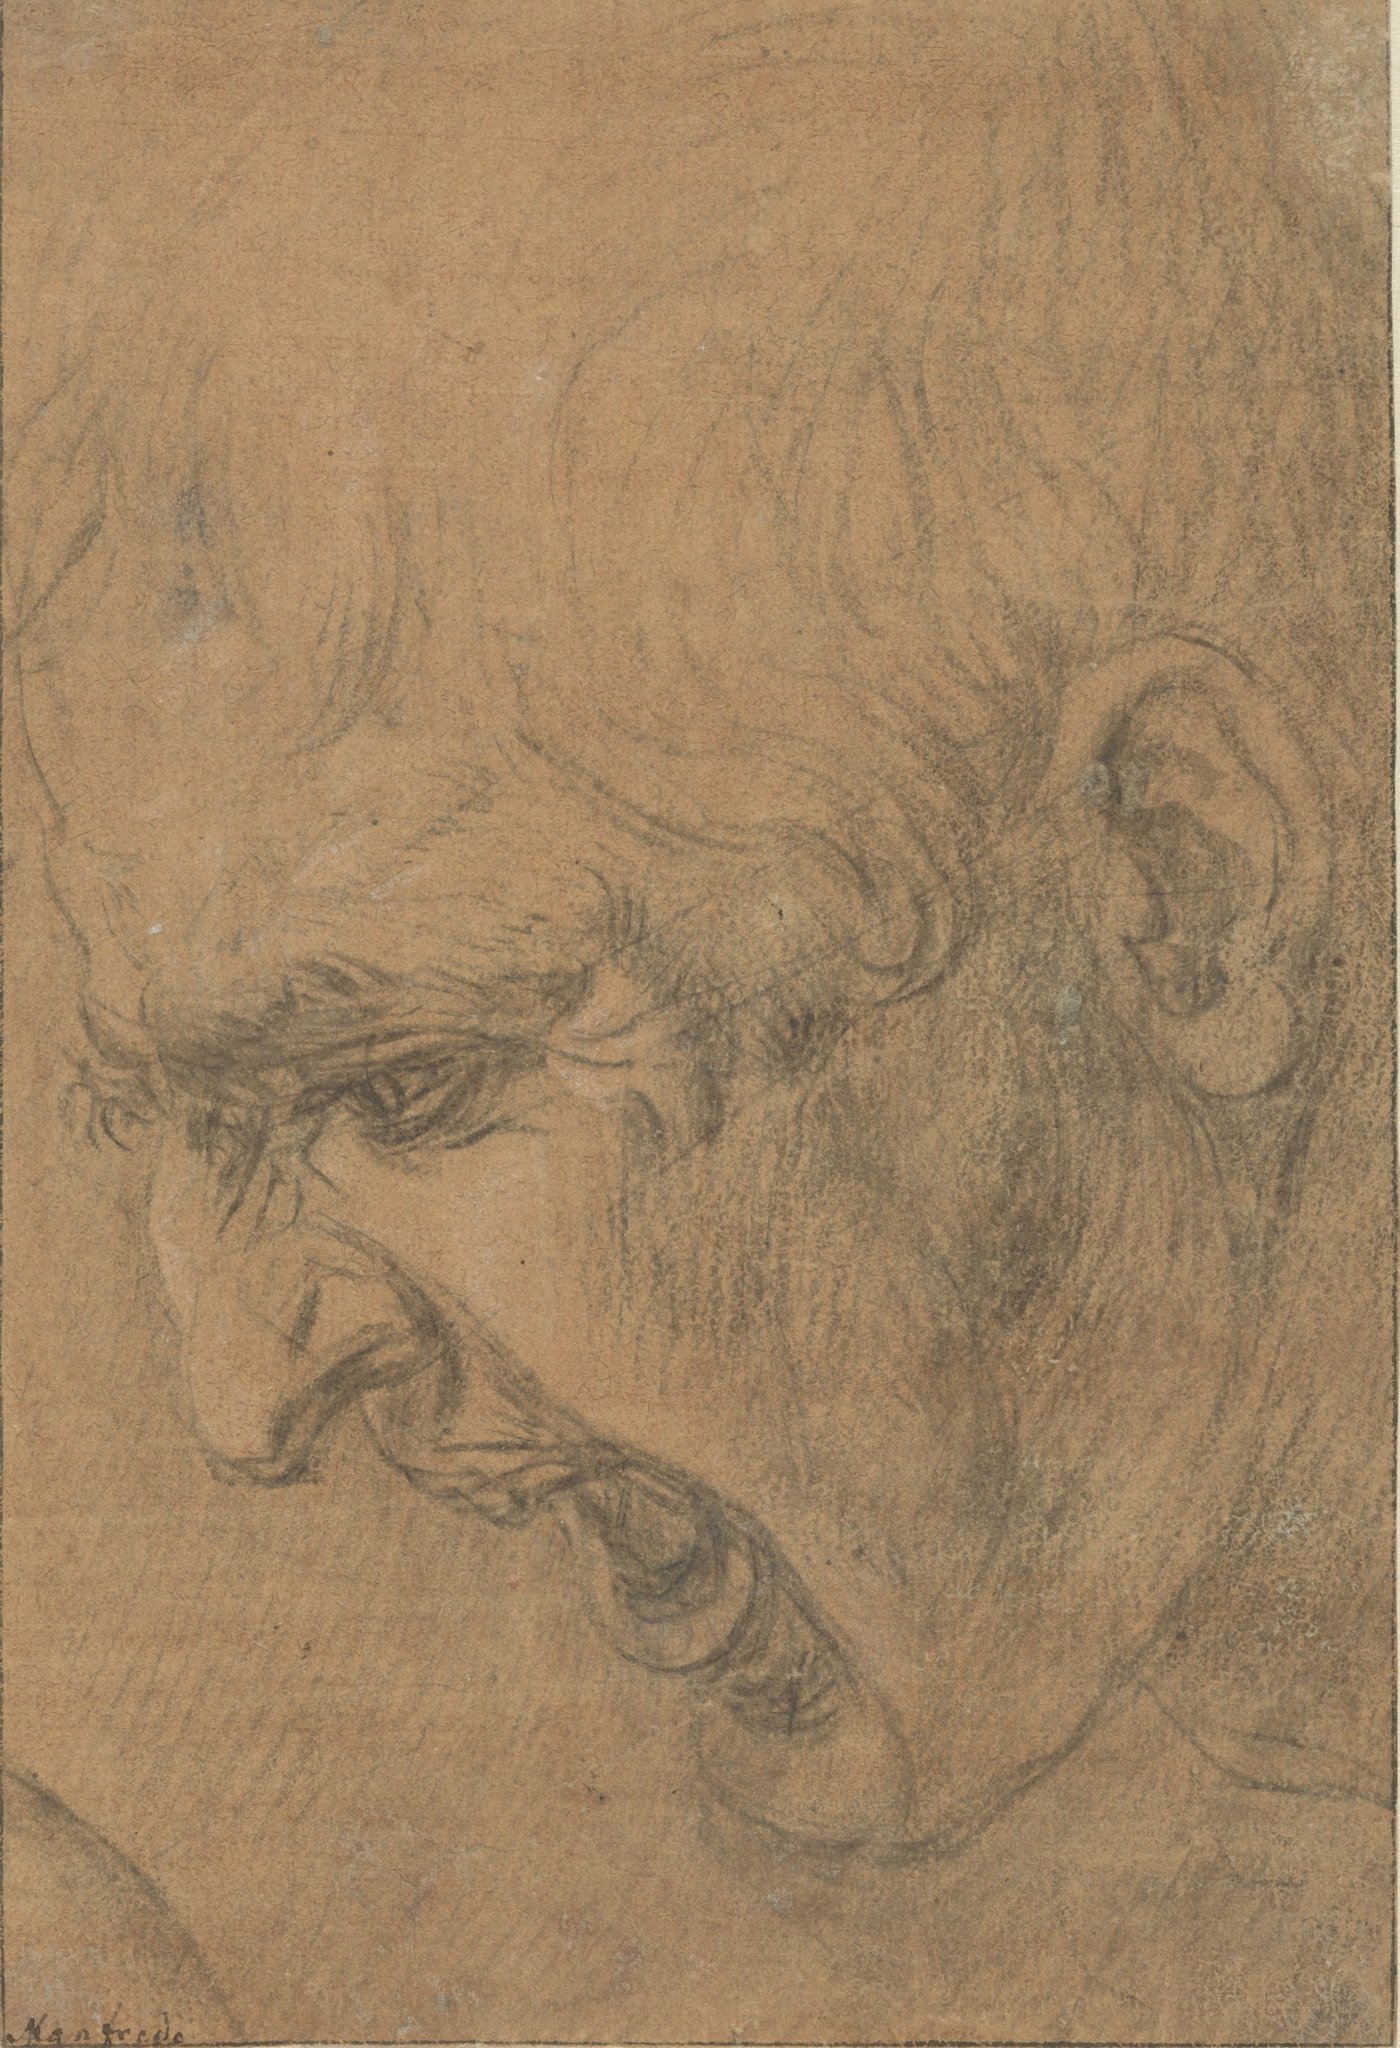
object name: drawing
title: Kop van een schreeuwende man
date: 1500-1600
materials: chalk